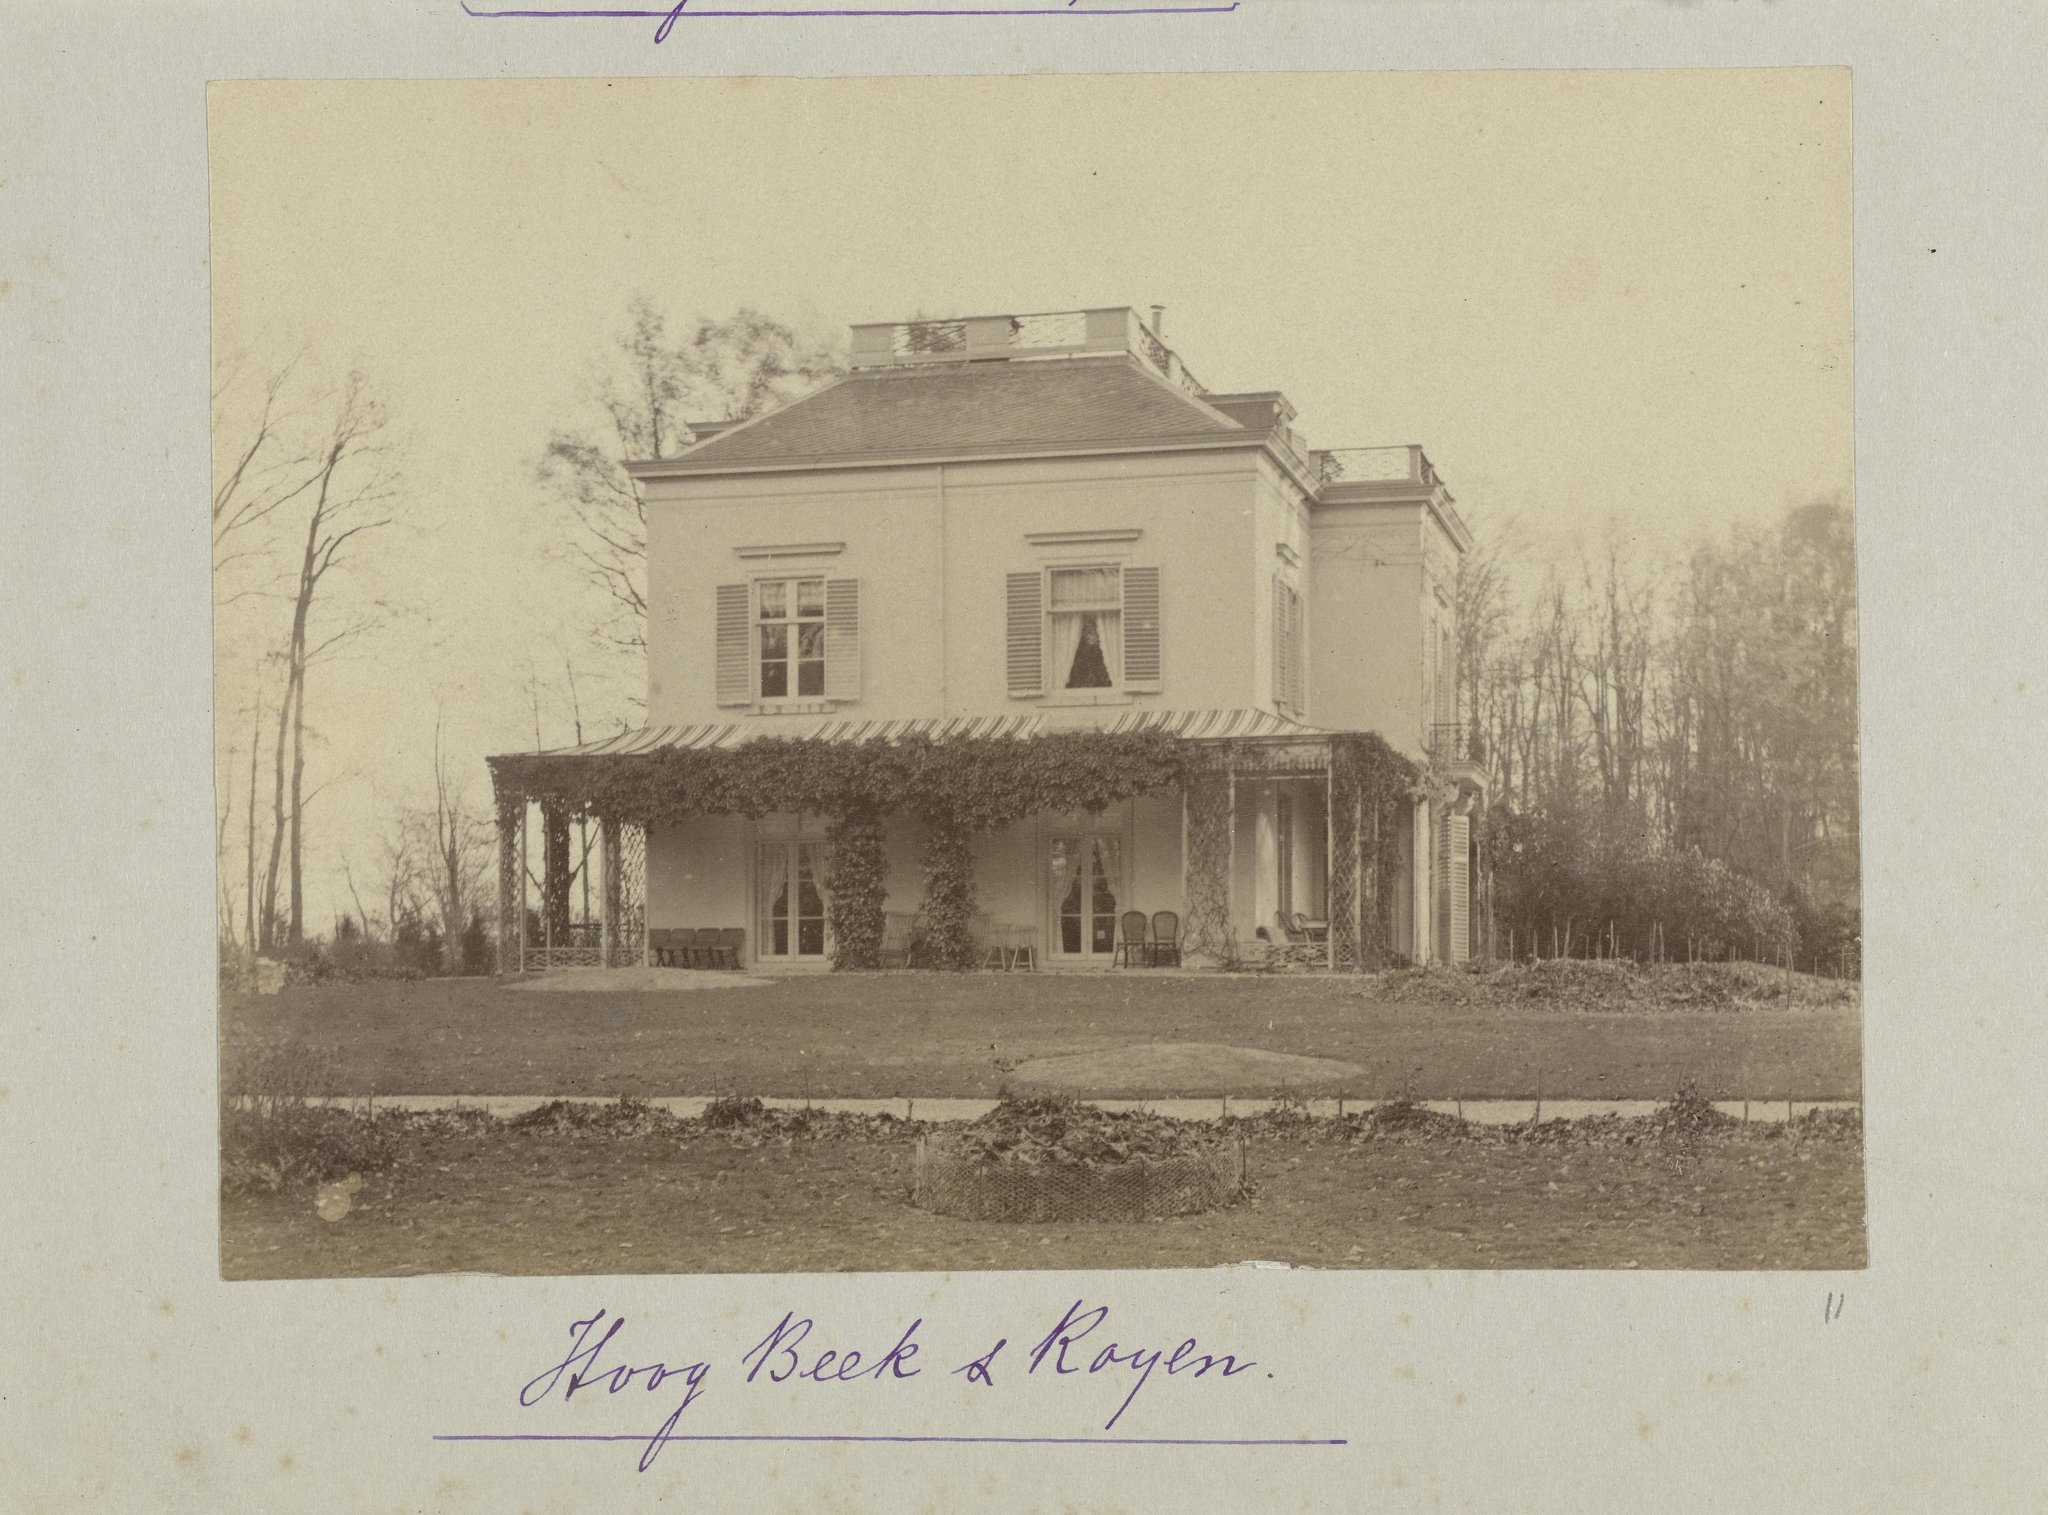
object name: photograph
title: Landhuis Hoog Beek en Rooyen, gelegen aan de Driebergse weg in Zeist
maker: henry pauw van wieldrecht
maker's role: fotograaf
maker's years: 1863-1912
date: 1888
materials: paper, photographic support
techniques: albumen print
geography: netherlands